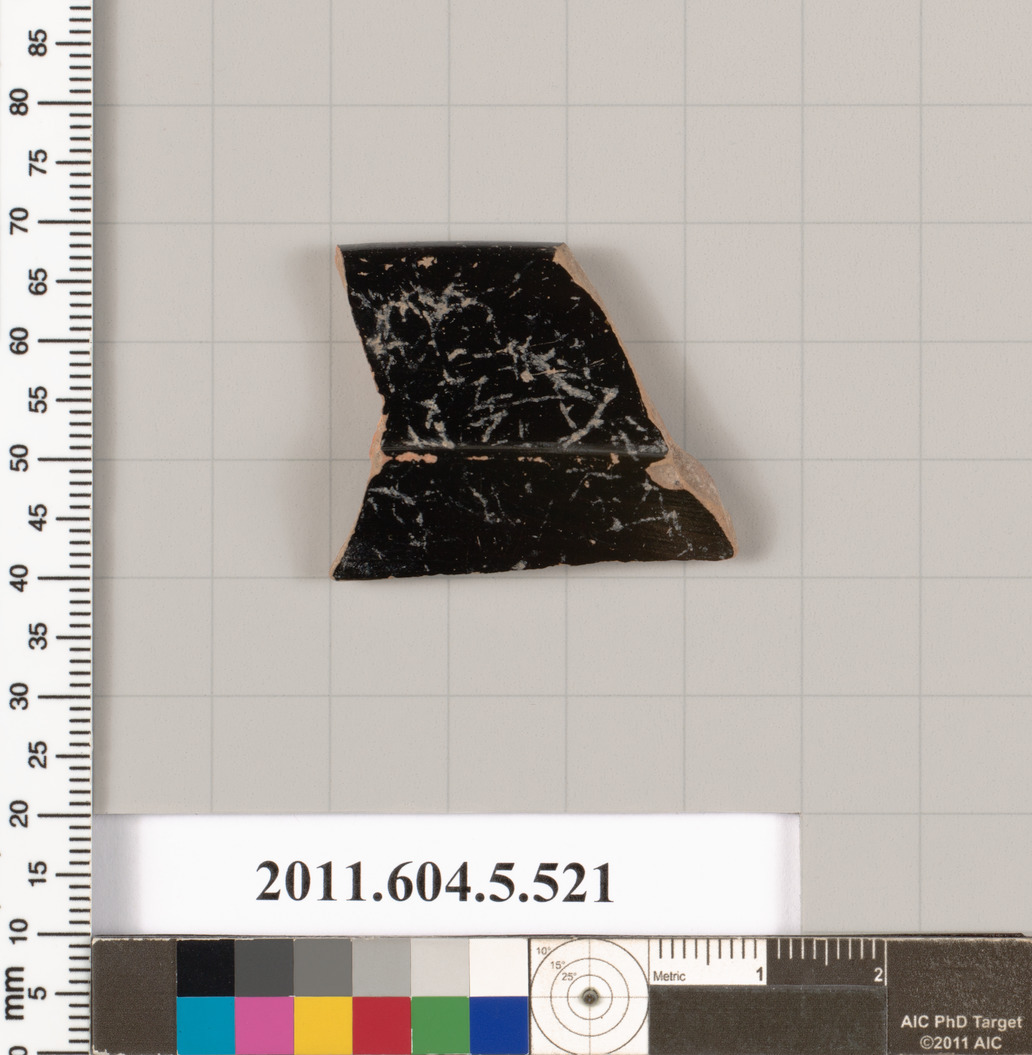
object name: kylix fragment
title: Terracotta rim fragment of a kylix (drinking cup)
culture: greek, attic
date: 600-401 BCE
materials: terracotta